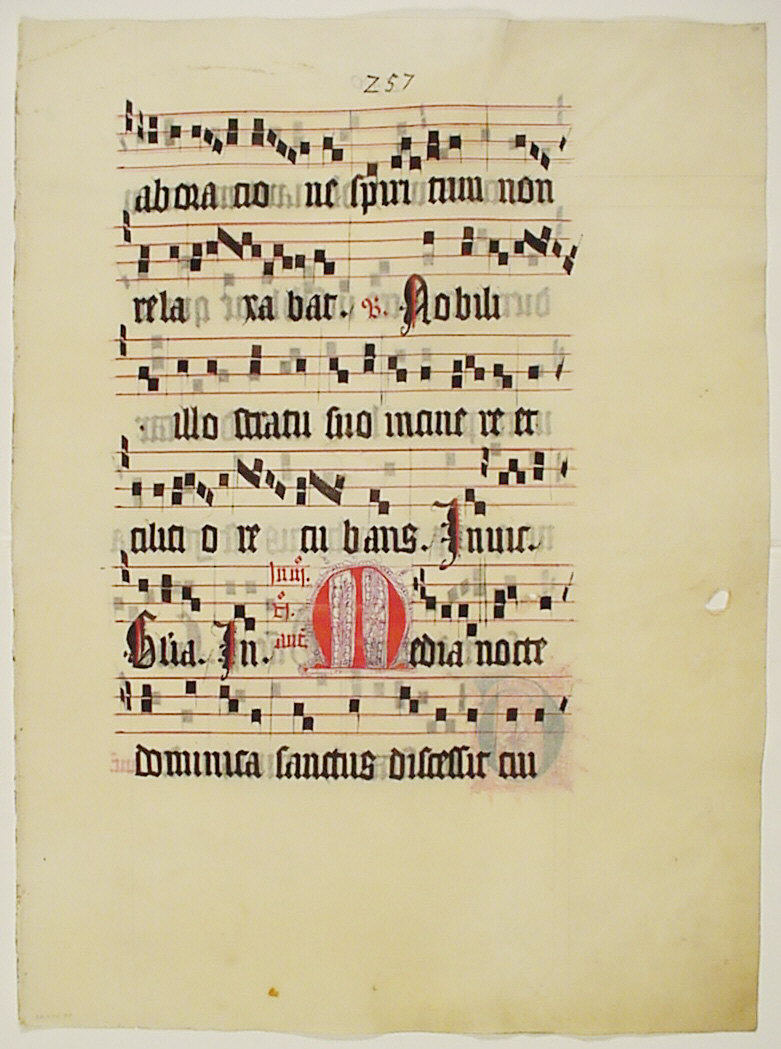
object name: antiphonary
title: Manuscript Leaf with Initial M, from an Antiphonary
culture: german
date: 1426-1450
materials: ink, metal leaf, parchment, paint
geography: germany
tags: music